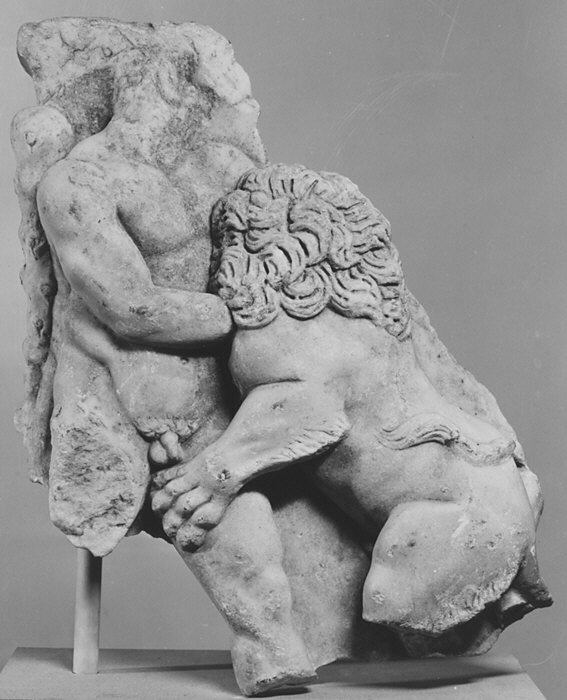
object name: sarcophagus fragment, herakles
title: Left corner of a marble sarcophagus: Herakles and the Nemean Lion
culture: roman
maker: lysippos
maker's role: artist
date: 170-180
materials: marble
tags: male nudes,lions,herakles